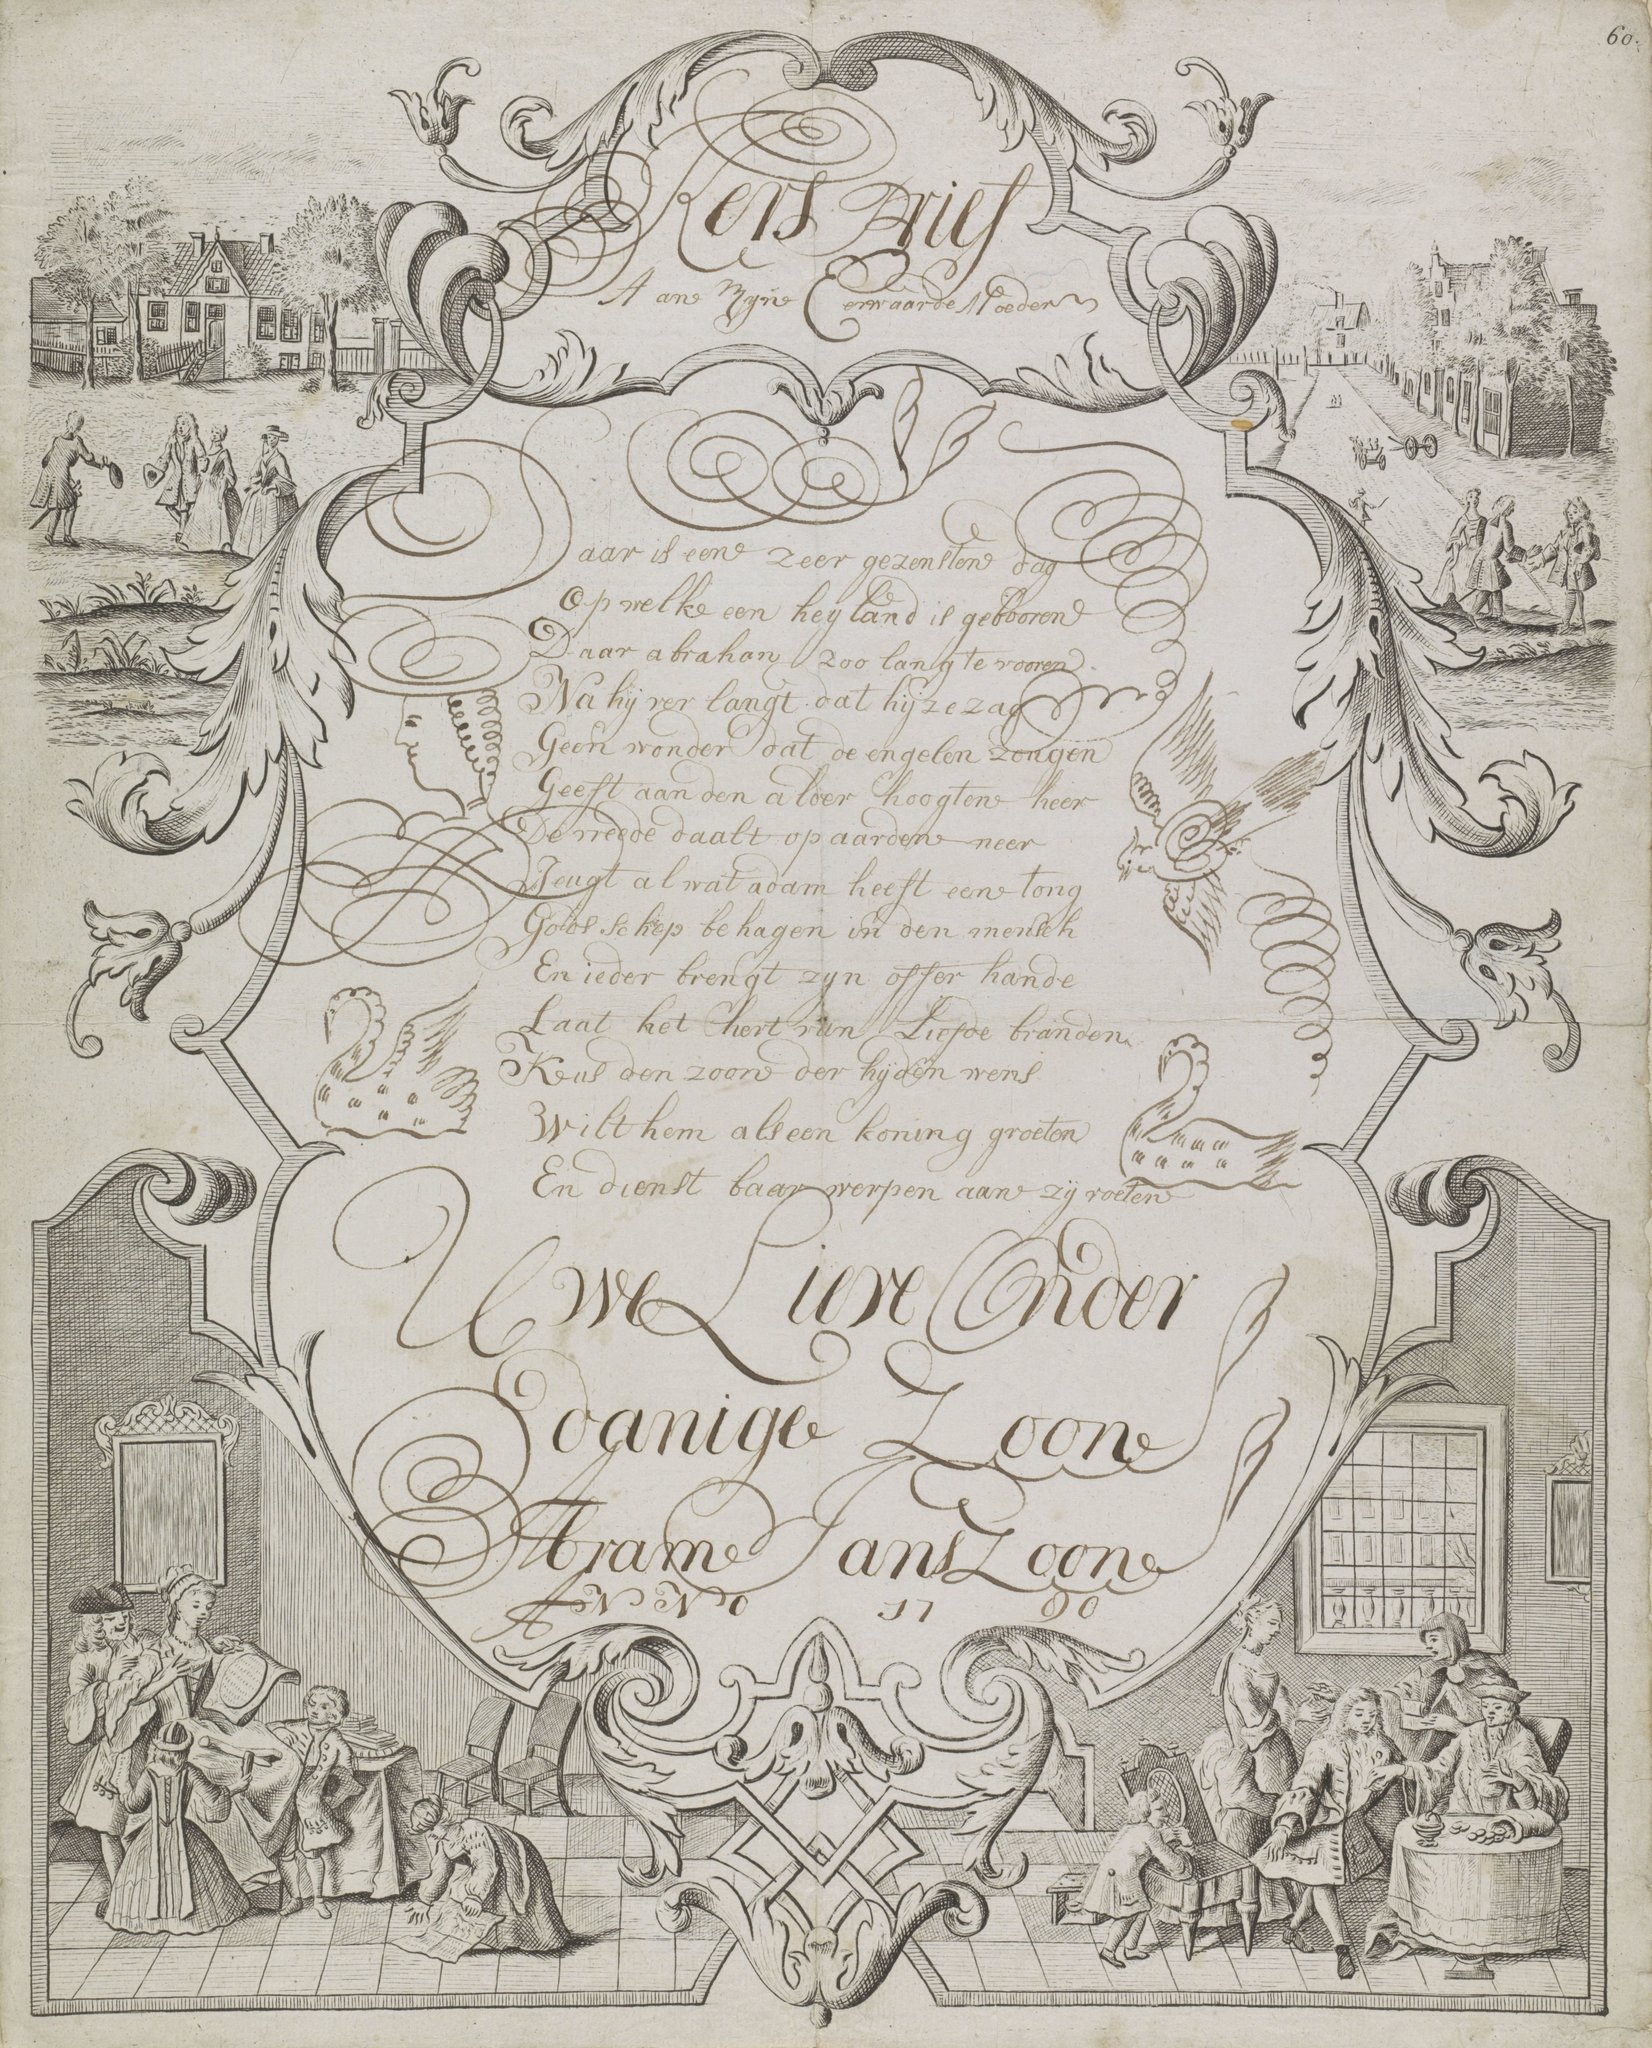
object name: print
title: Wensbrief met decoratief kader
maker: Anonymous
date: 1790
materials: ink, paper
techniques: calligraphy, etching, pen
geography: netherlands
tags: parents with their children, human types, characters (human types)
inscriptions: collector's mark: Lugt 2760, inscription: ‘Kers brief / Aan mijne eerwaarde moder / Daar is een zeer gezen[...]len dag ...’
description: Wensbrief met beschreven cartouche binnen een decoratief kader met voorstellingen van kinderen die hun moeder wensbrieven aanbieden en andere figuren en bezigheden. Handgeschreven bericht in kalligrafie (Kerstbrief) door Abraham Jansz aan zijn moeder. Genummerd rechtsboven: 60.